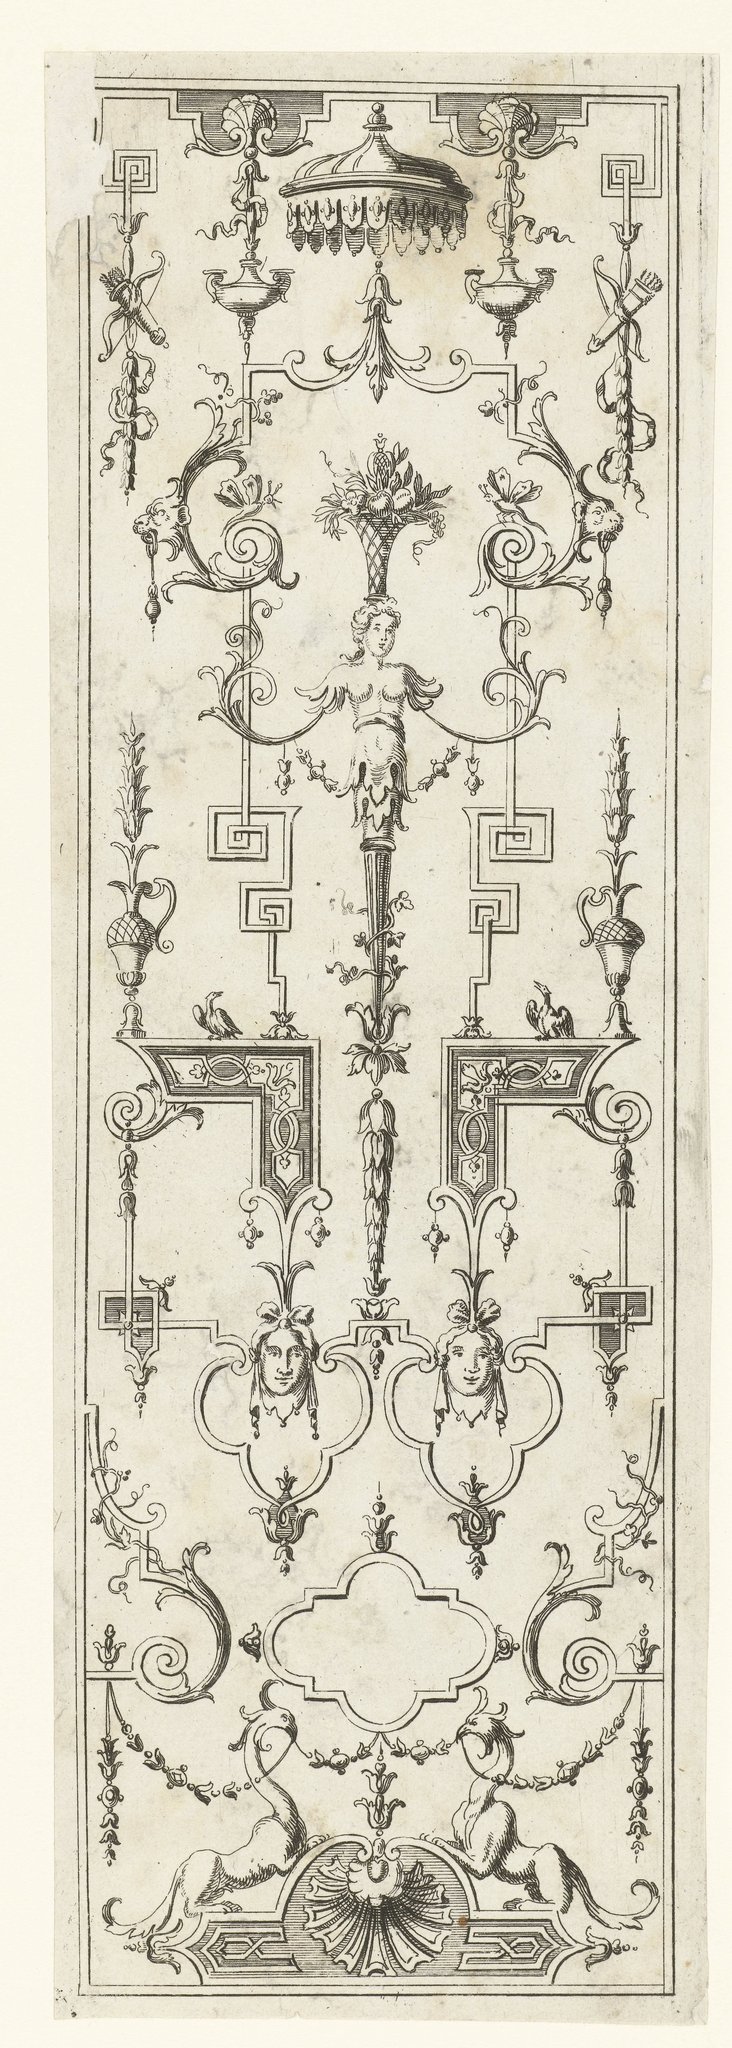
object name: print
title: Moderne grotesken met vrouwelijke herme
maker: jeremias wolf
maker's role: print maker, publisher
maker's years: 1663-1724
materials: paper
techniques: etching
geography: france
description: De herme draagt een mand met fruit en bladeren op haar hoofd.